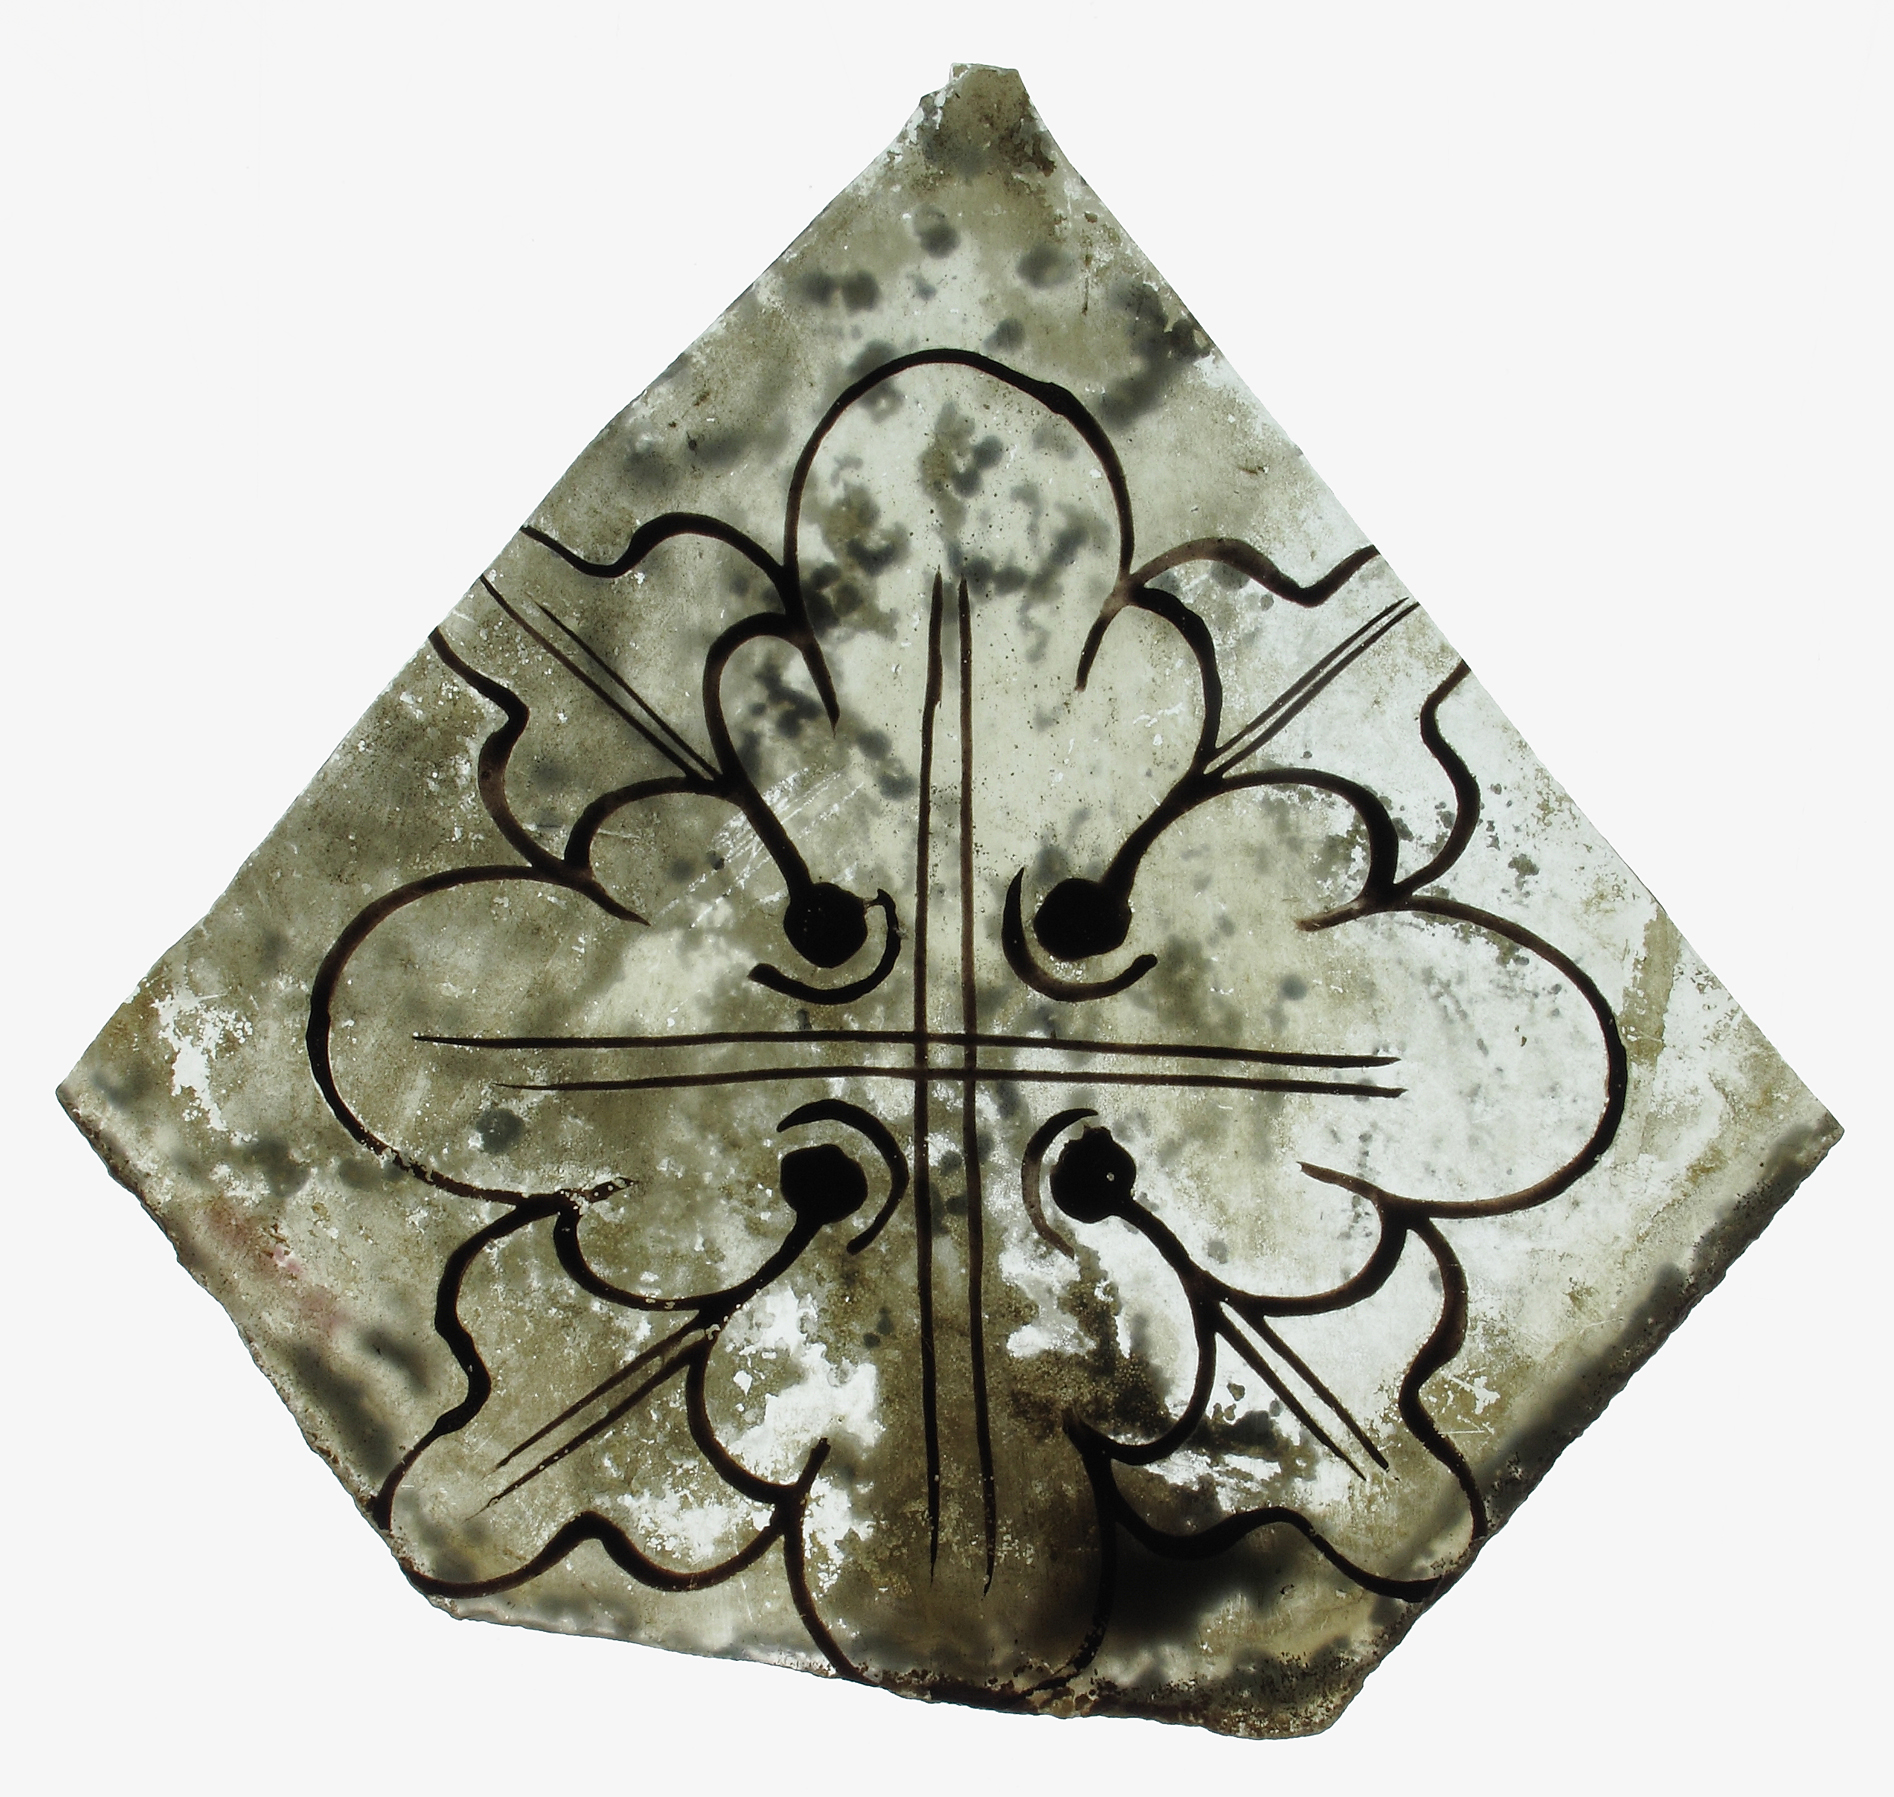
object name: fragment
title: Glass Fragment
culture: european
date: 1301-1400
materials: glass